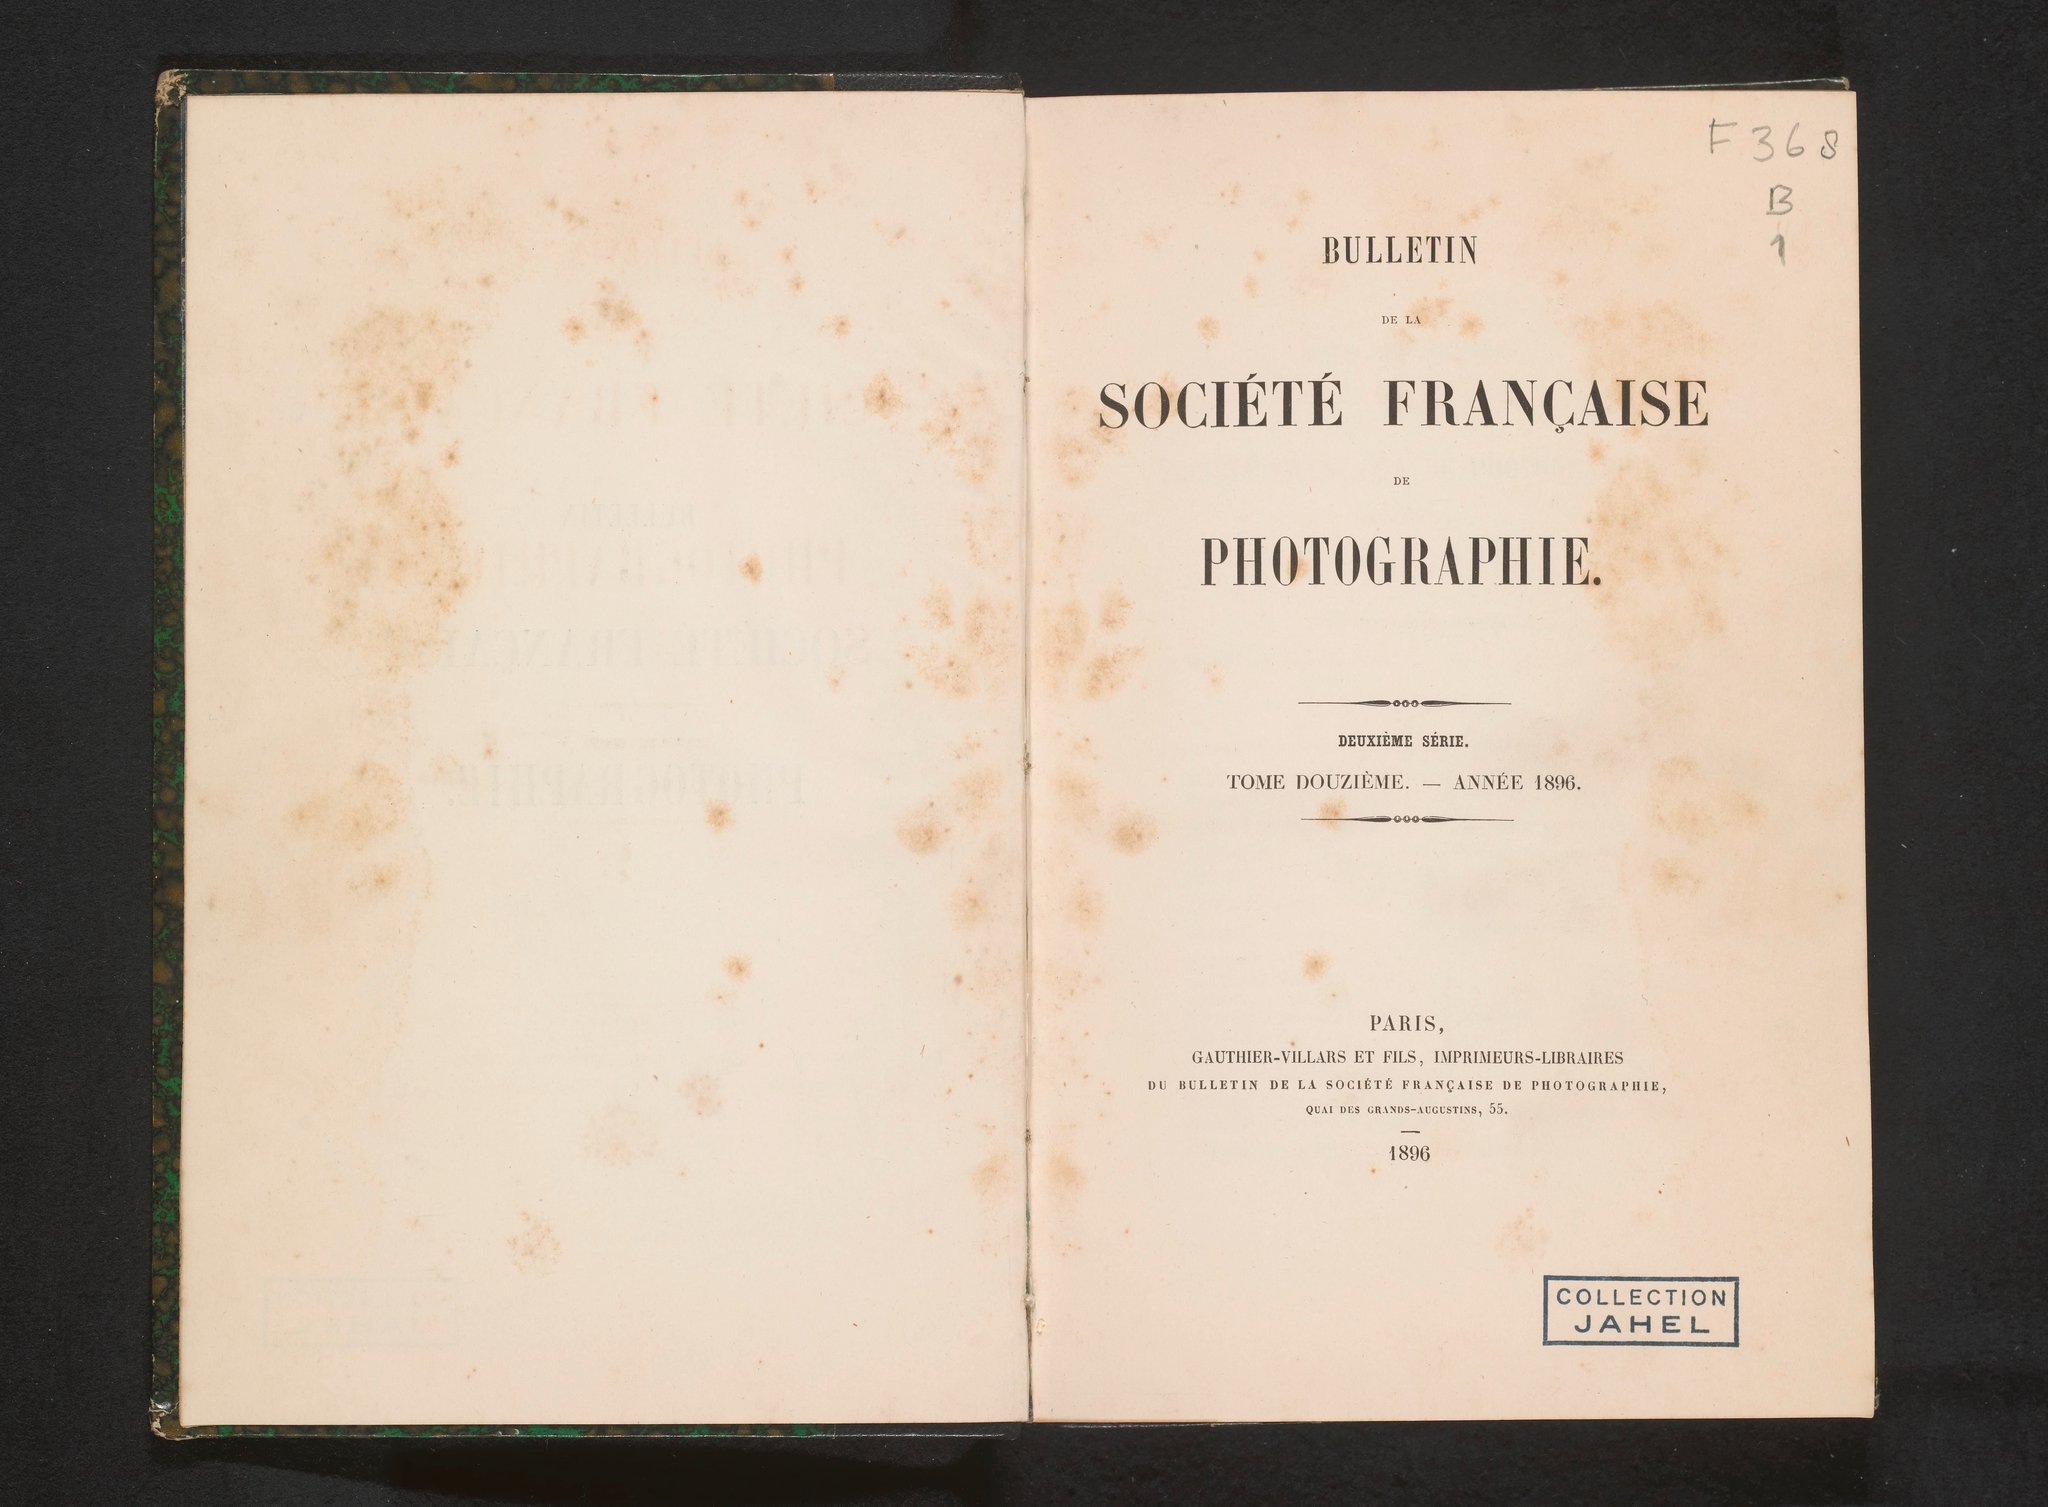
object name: book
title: Bulletin de la Société française de photographie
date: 1896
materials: cardboard, leather, paper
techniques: marbled paper, photograph, photoaquatint, printing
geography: paris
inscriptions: inscription: ‘Collection Jahel’